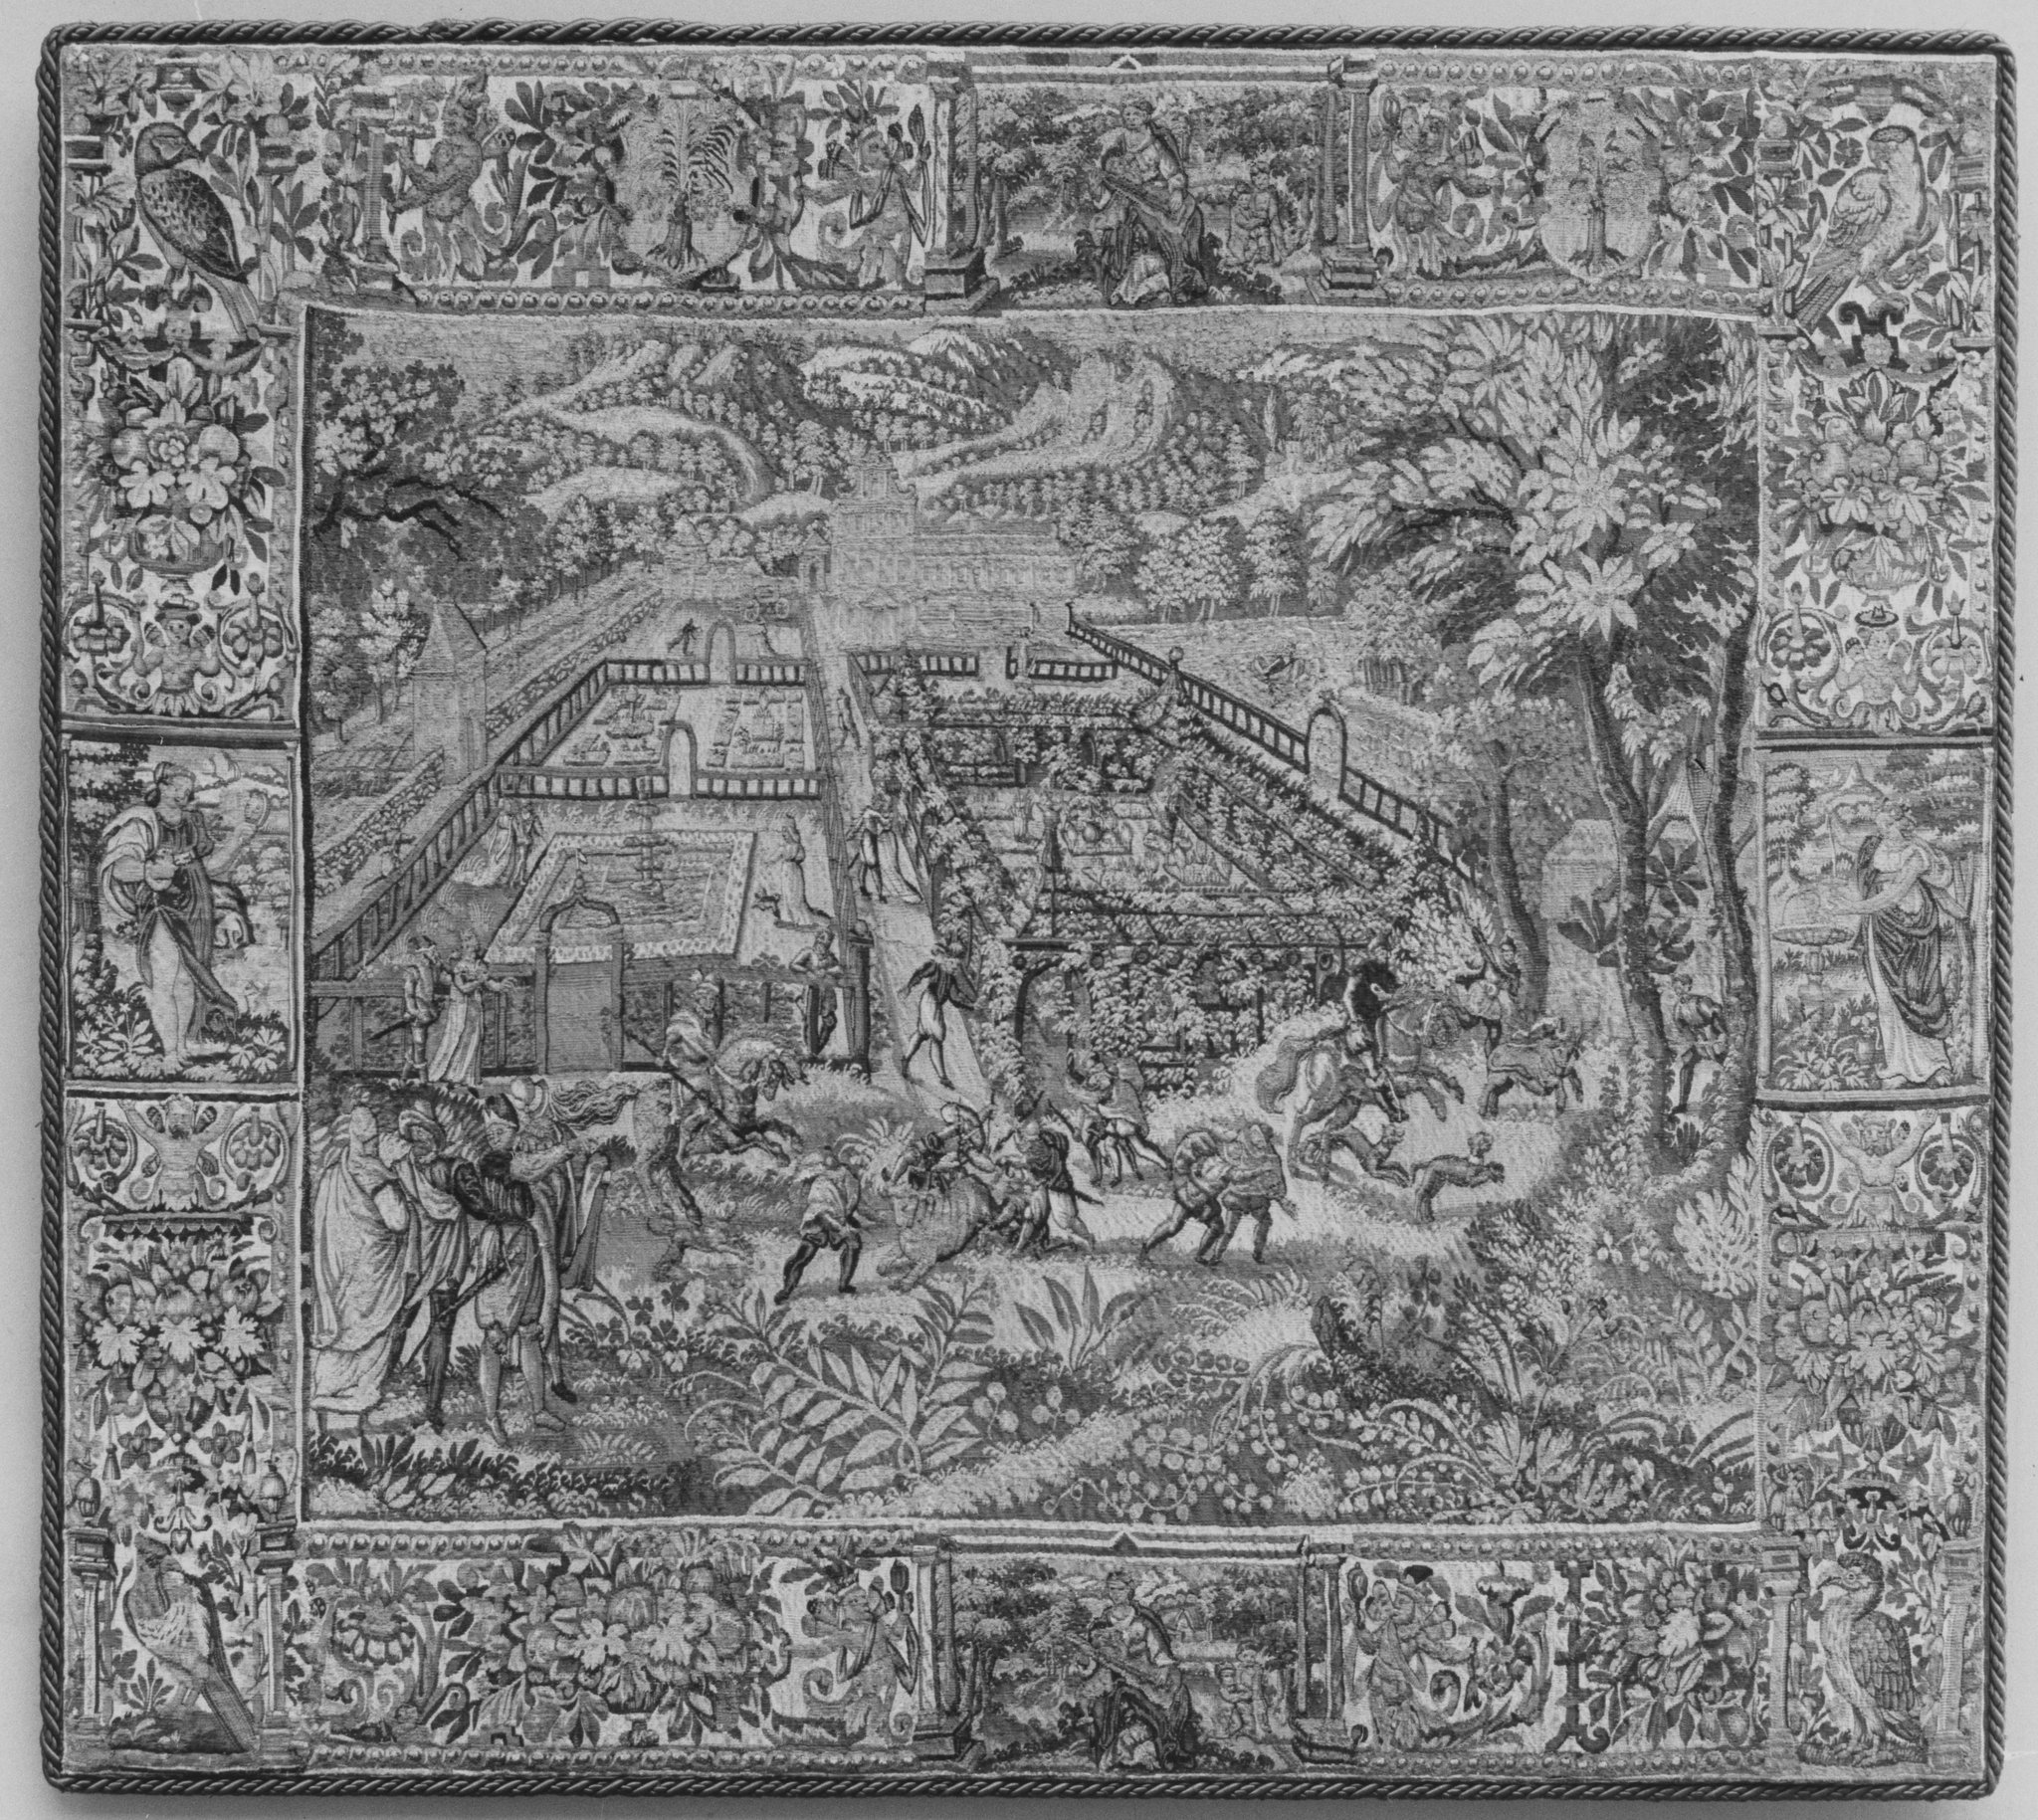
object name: tapestry fragment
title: Garden and Hunting Scene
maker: unidentified weaver's mark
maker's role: maker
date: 1567-1600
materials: silk, wool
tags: gardens,men,hunting,bulls,dogs,horses